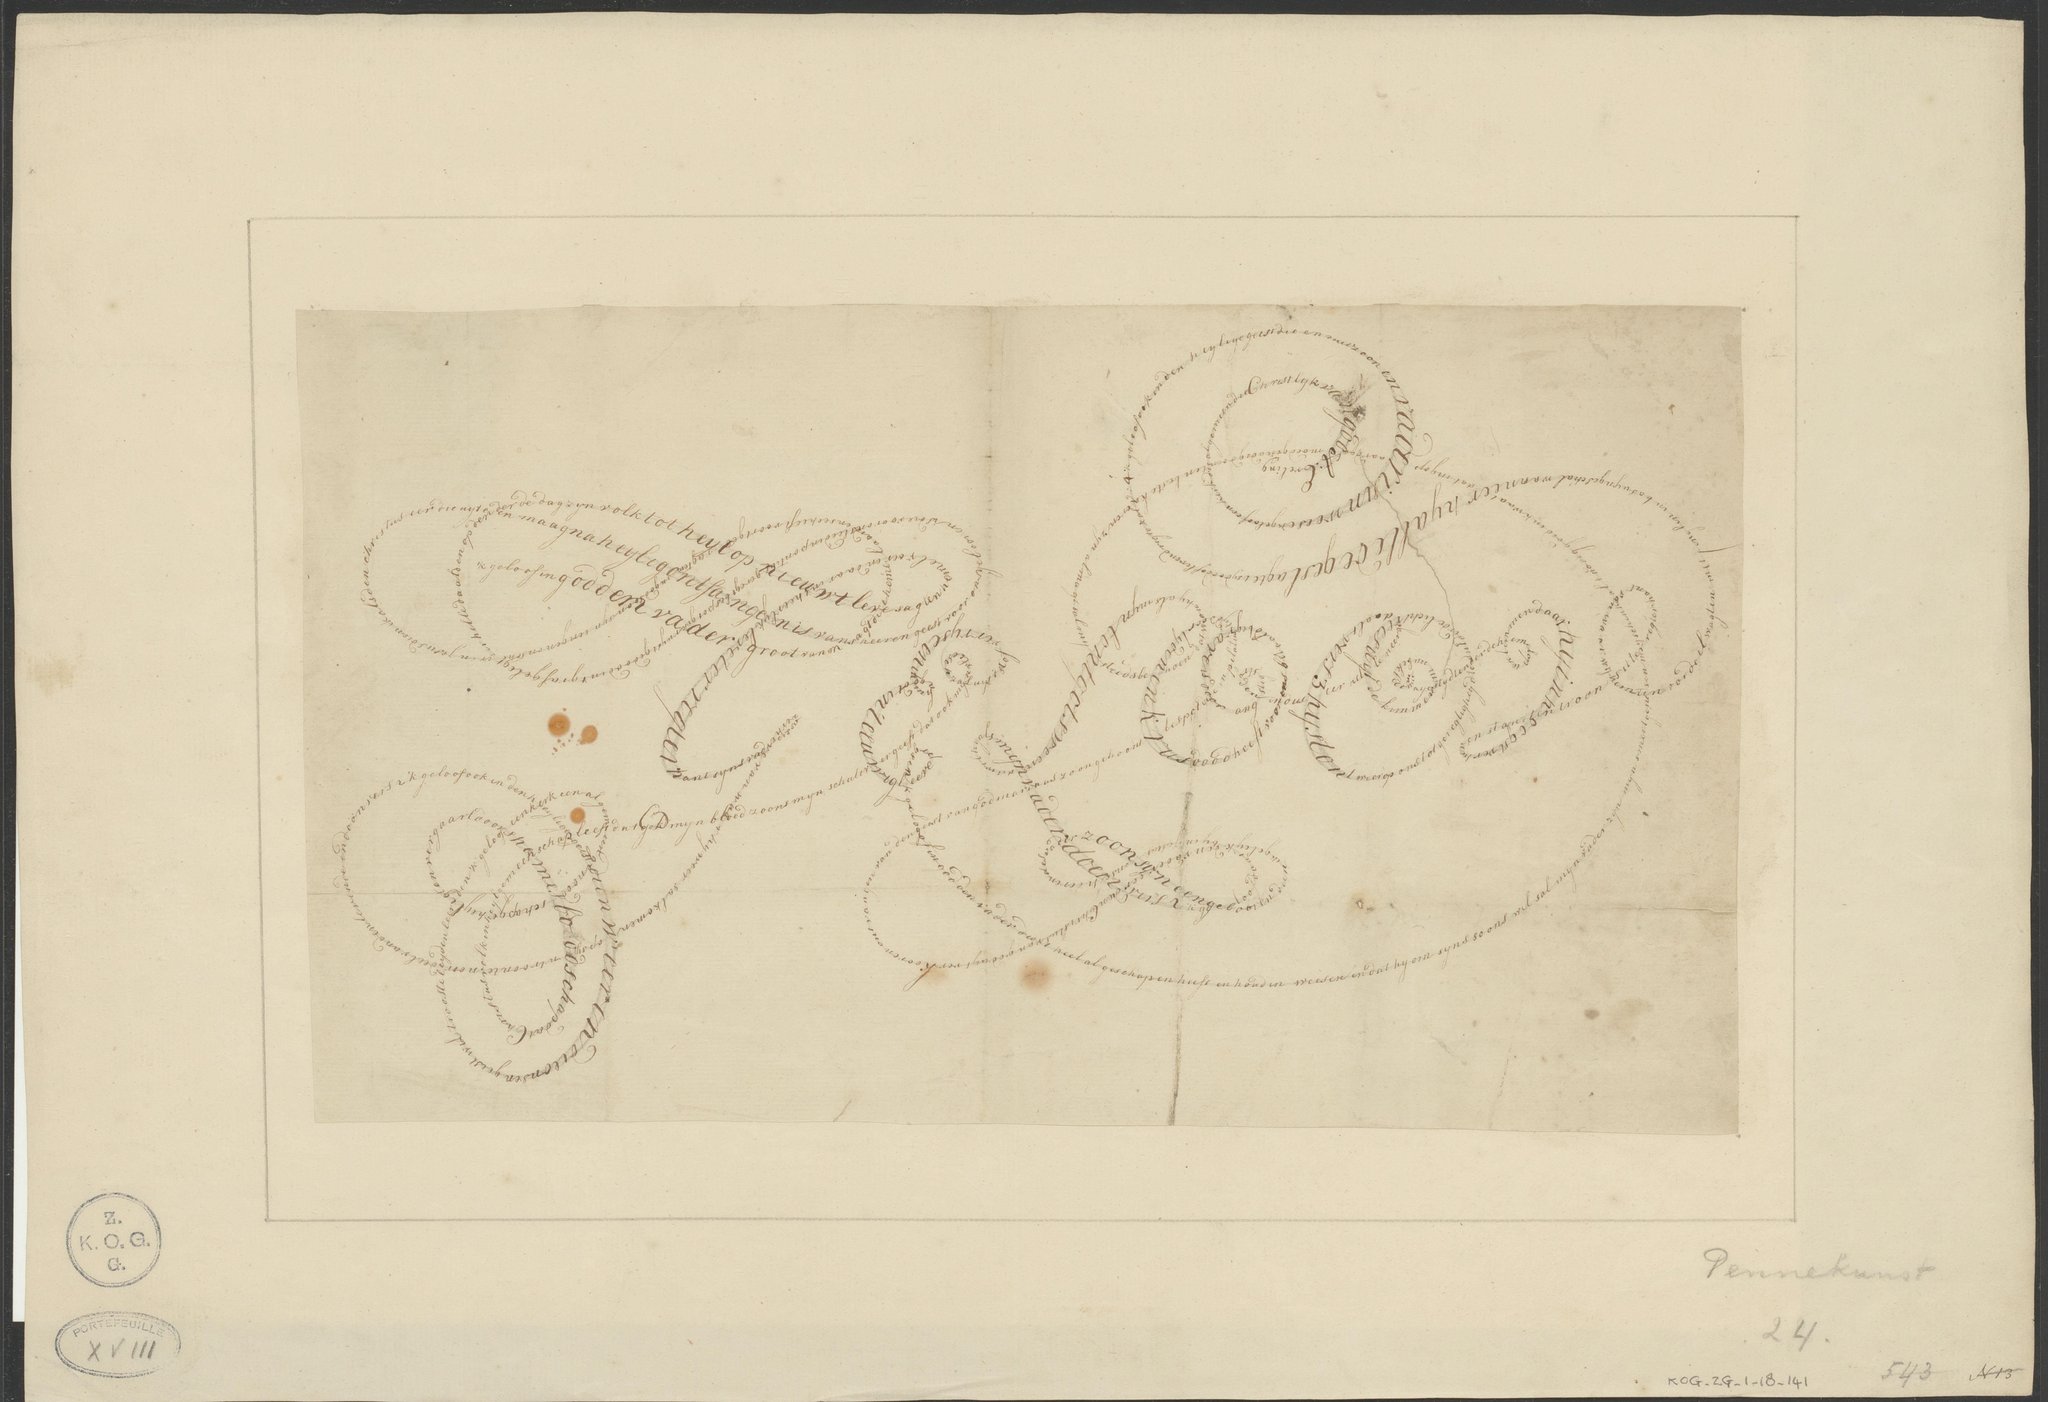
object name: calligraphy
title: Kalligrafie op Geloof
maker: Anonymous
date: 1800-1849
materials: ink, paper, pencil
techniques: pen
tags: calligraphy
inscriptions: stamp, collector's mark: Lugt 1641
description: Kalligrafie met de tekst: Geloov. De lijnen van de letters van geloov bestaan uit tekst. Onderwerpsrubrieken binnen de Atlas Zeden en Gewoonten: Schoone kunsten, Pennekunst.